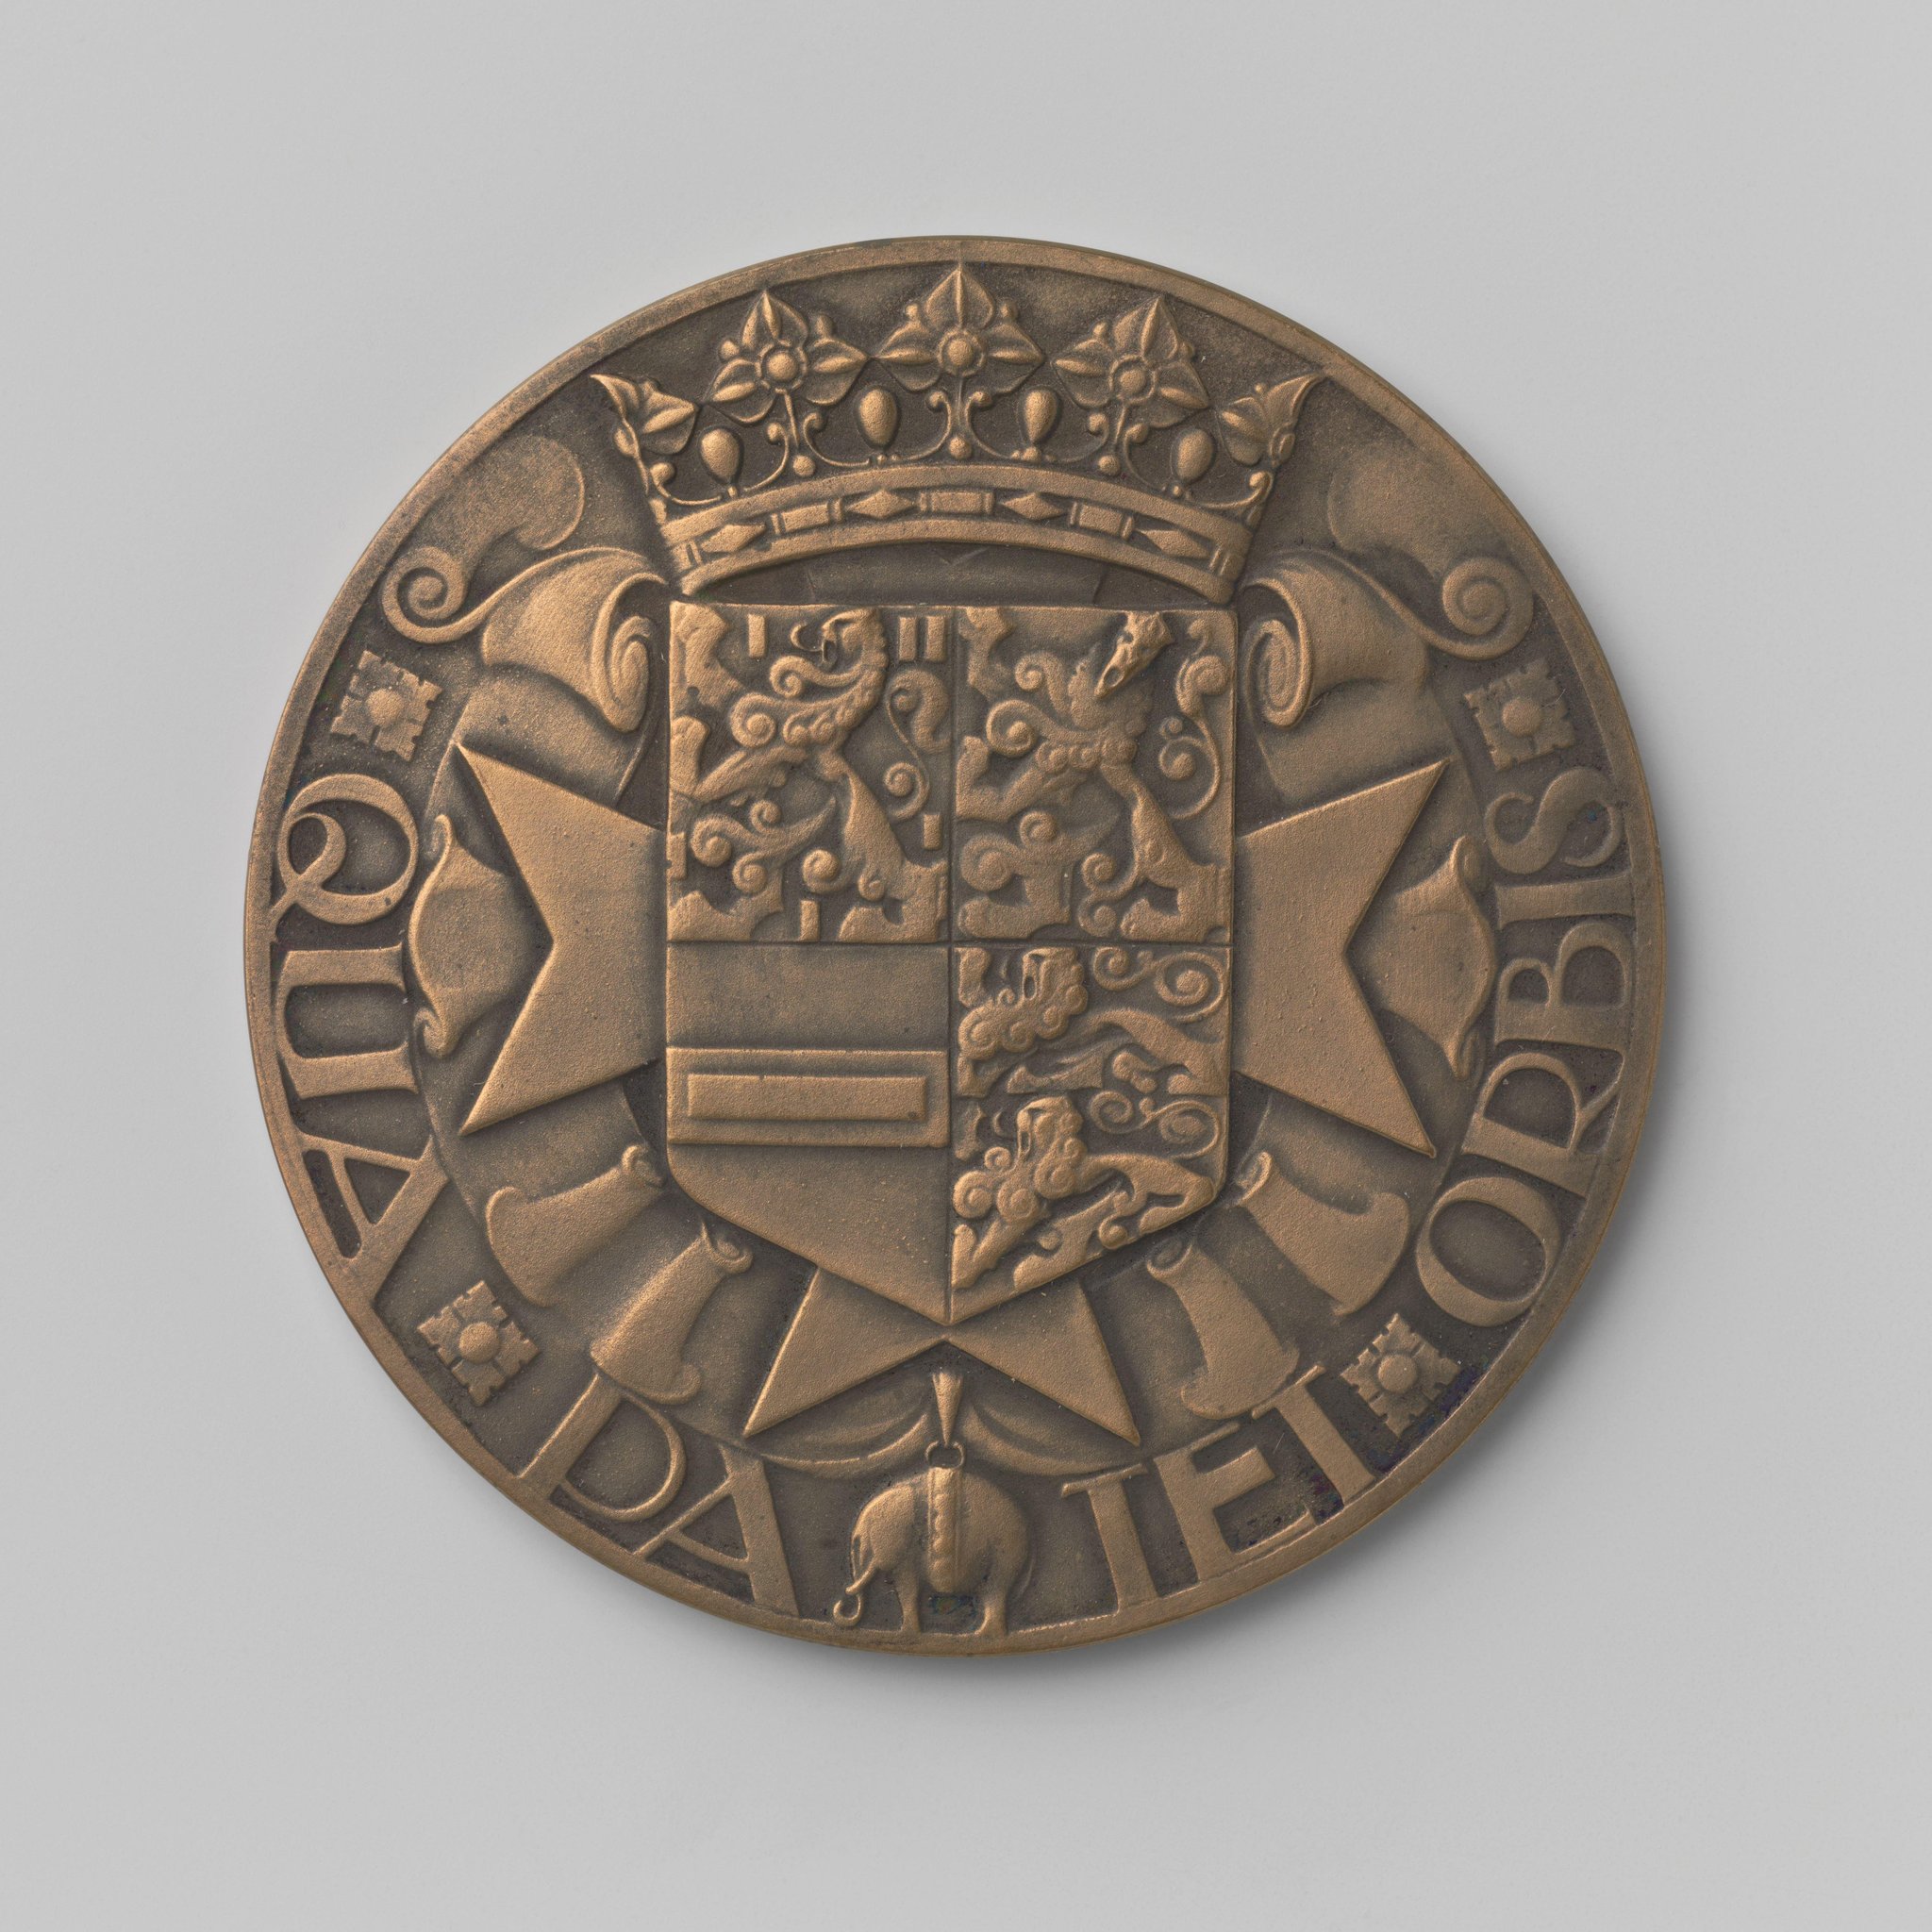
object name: history medal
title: Johan Maurits van Nassau tweehonderdvijftig jaar overleden (Vereniging voor Penningkunst 1929, tweede penning)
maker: chris van der hoef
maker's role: ceramicist, draughtsman, sculptor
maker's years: 1875-1933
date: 1929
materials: bronze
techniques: striking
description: Bronzen penning, op de voorzijde het gekroonde wapenschild van Johan Maurits op de versierselen van twee ridderorden, met omschrift, op de keerzijde een GWC-monogram met omschrift, met verklaring.